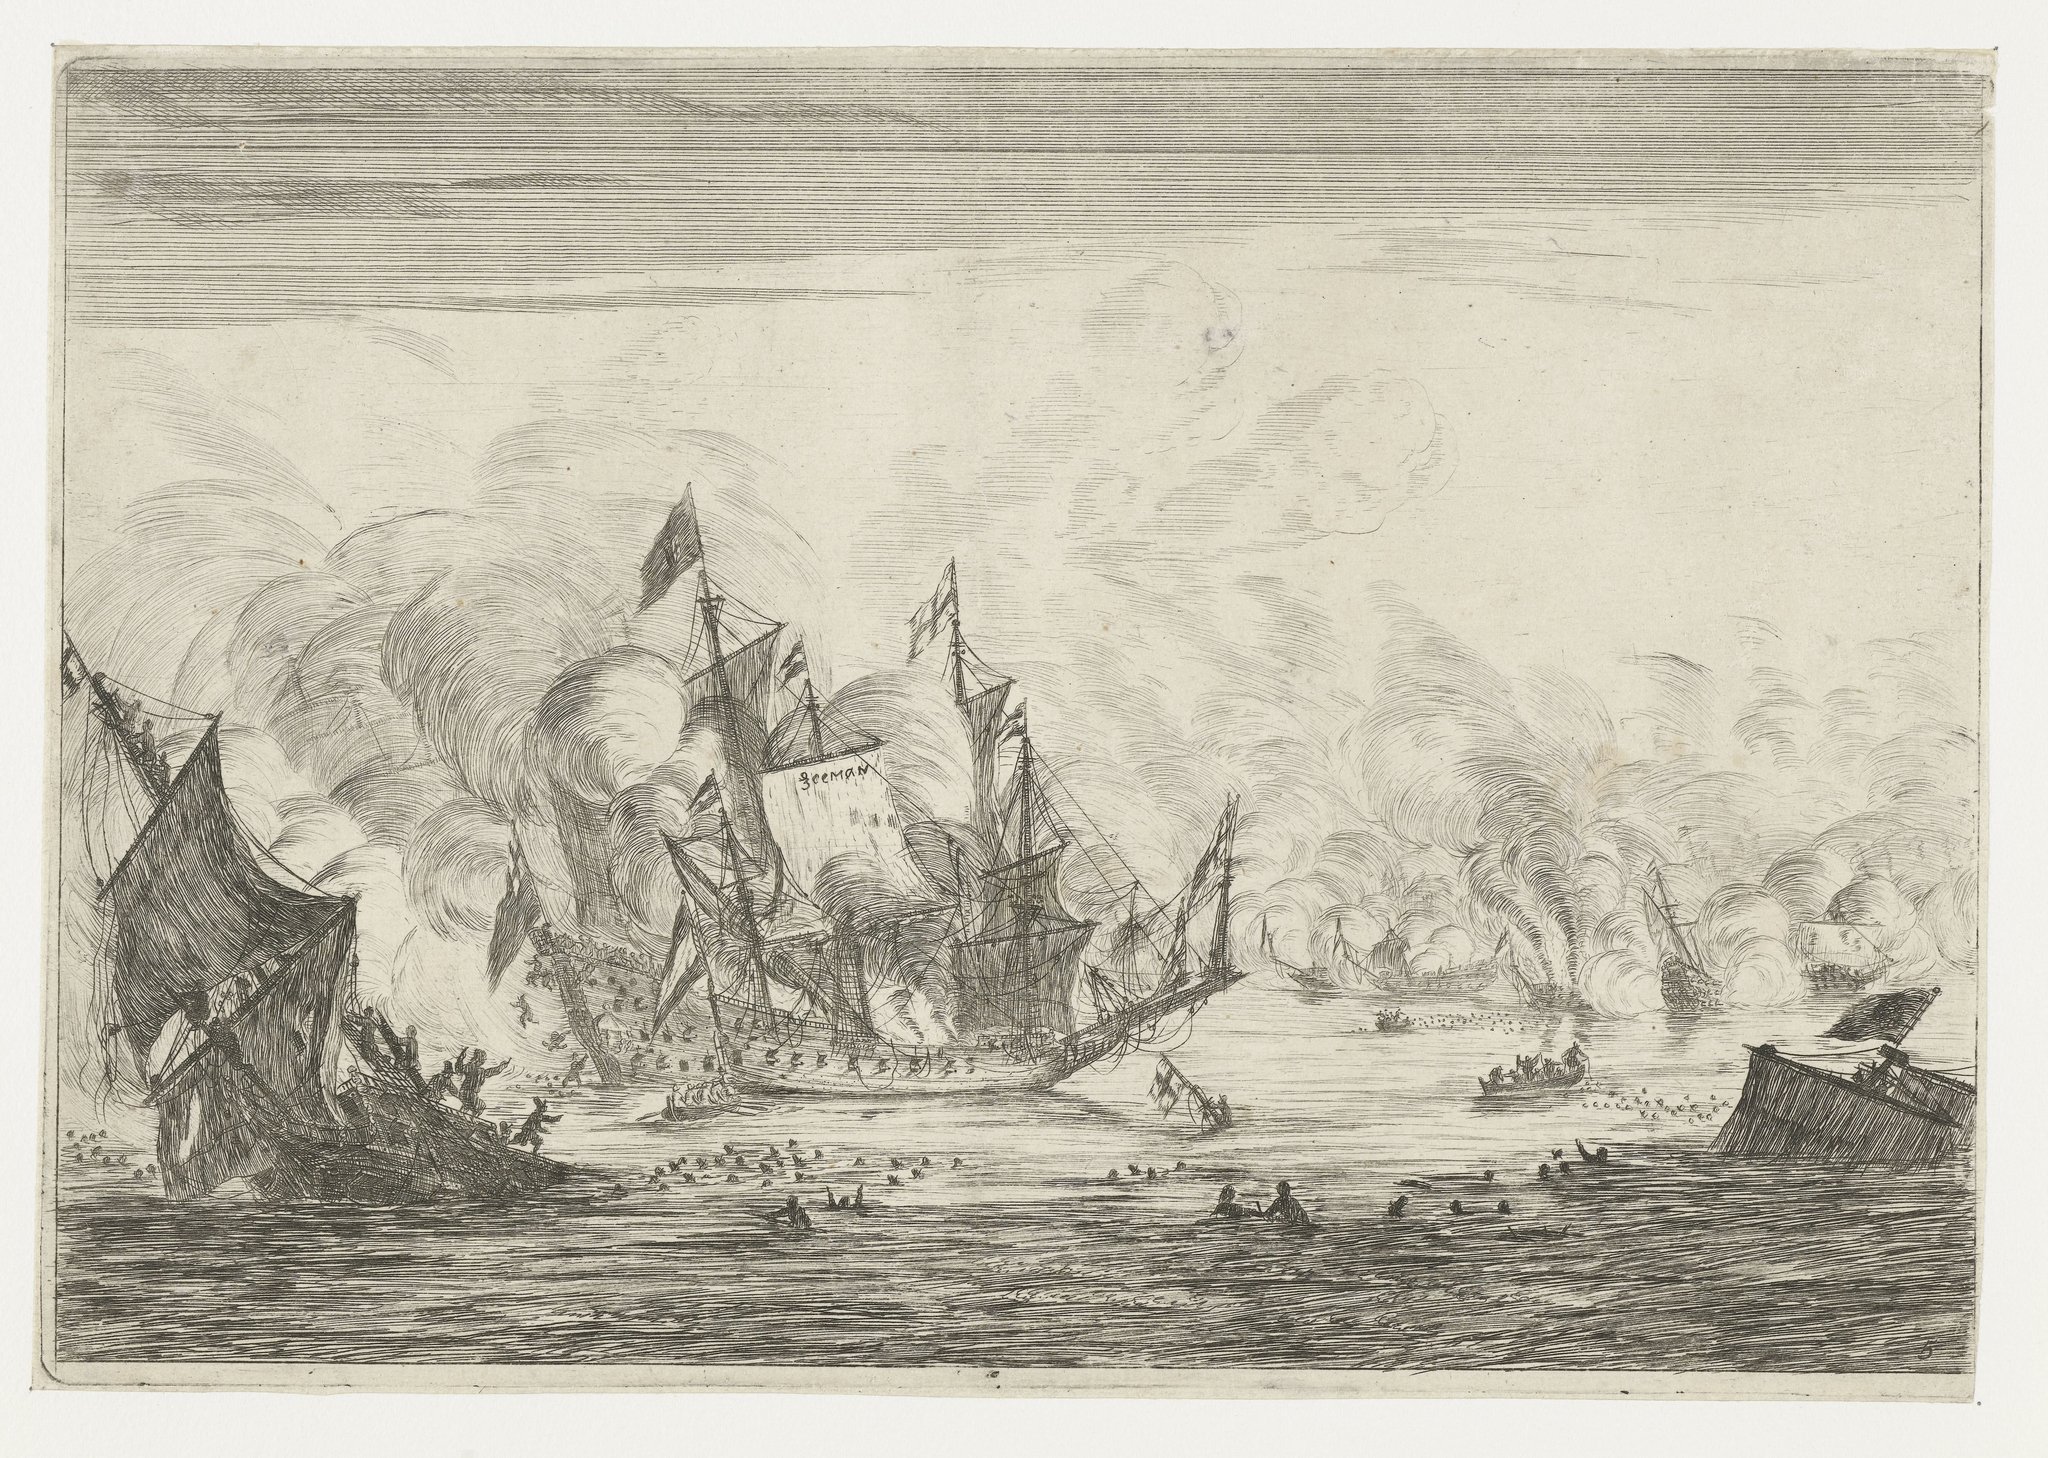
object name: print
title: Nieuwe Scheeps Batalien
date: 1652-1670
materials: paper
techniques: drypoint, etching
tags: warfare; military affairs (+ sailing-ships), battle, fighting in general (+ naval force)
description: Zeeslag met een aantal zinkende en brandende schepen en vele mensen in het water.